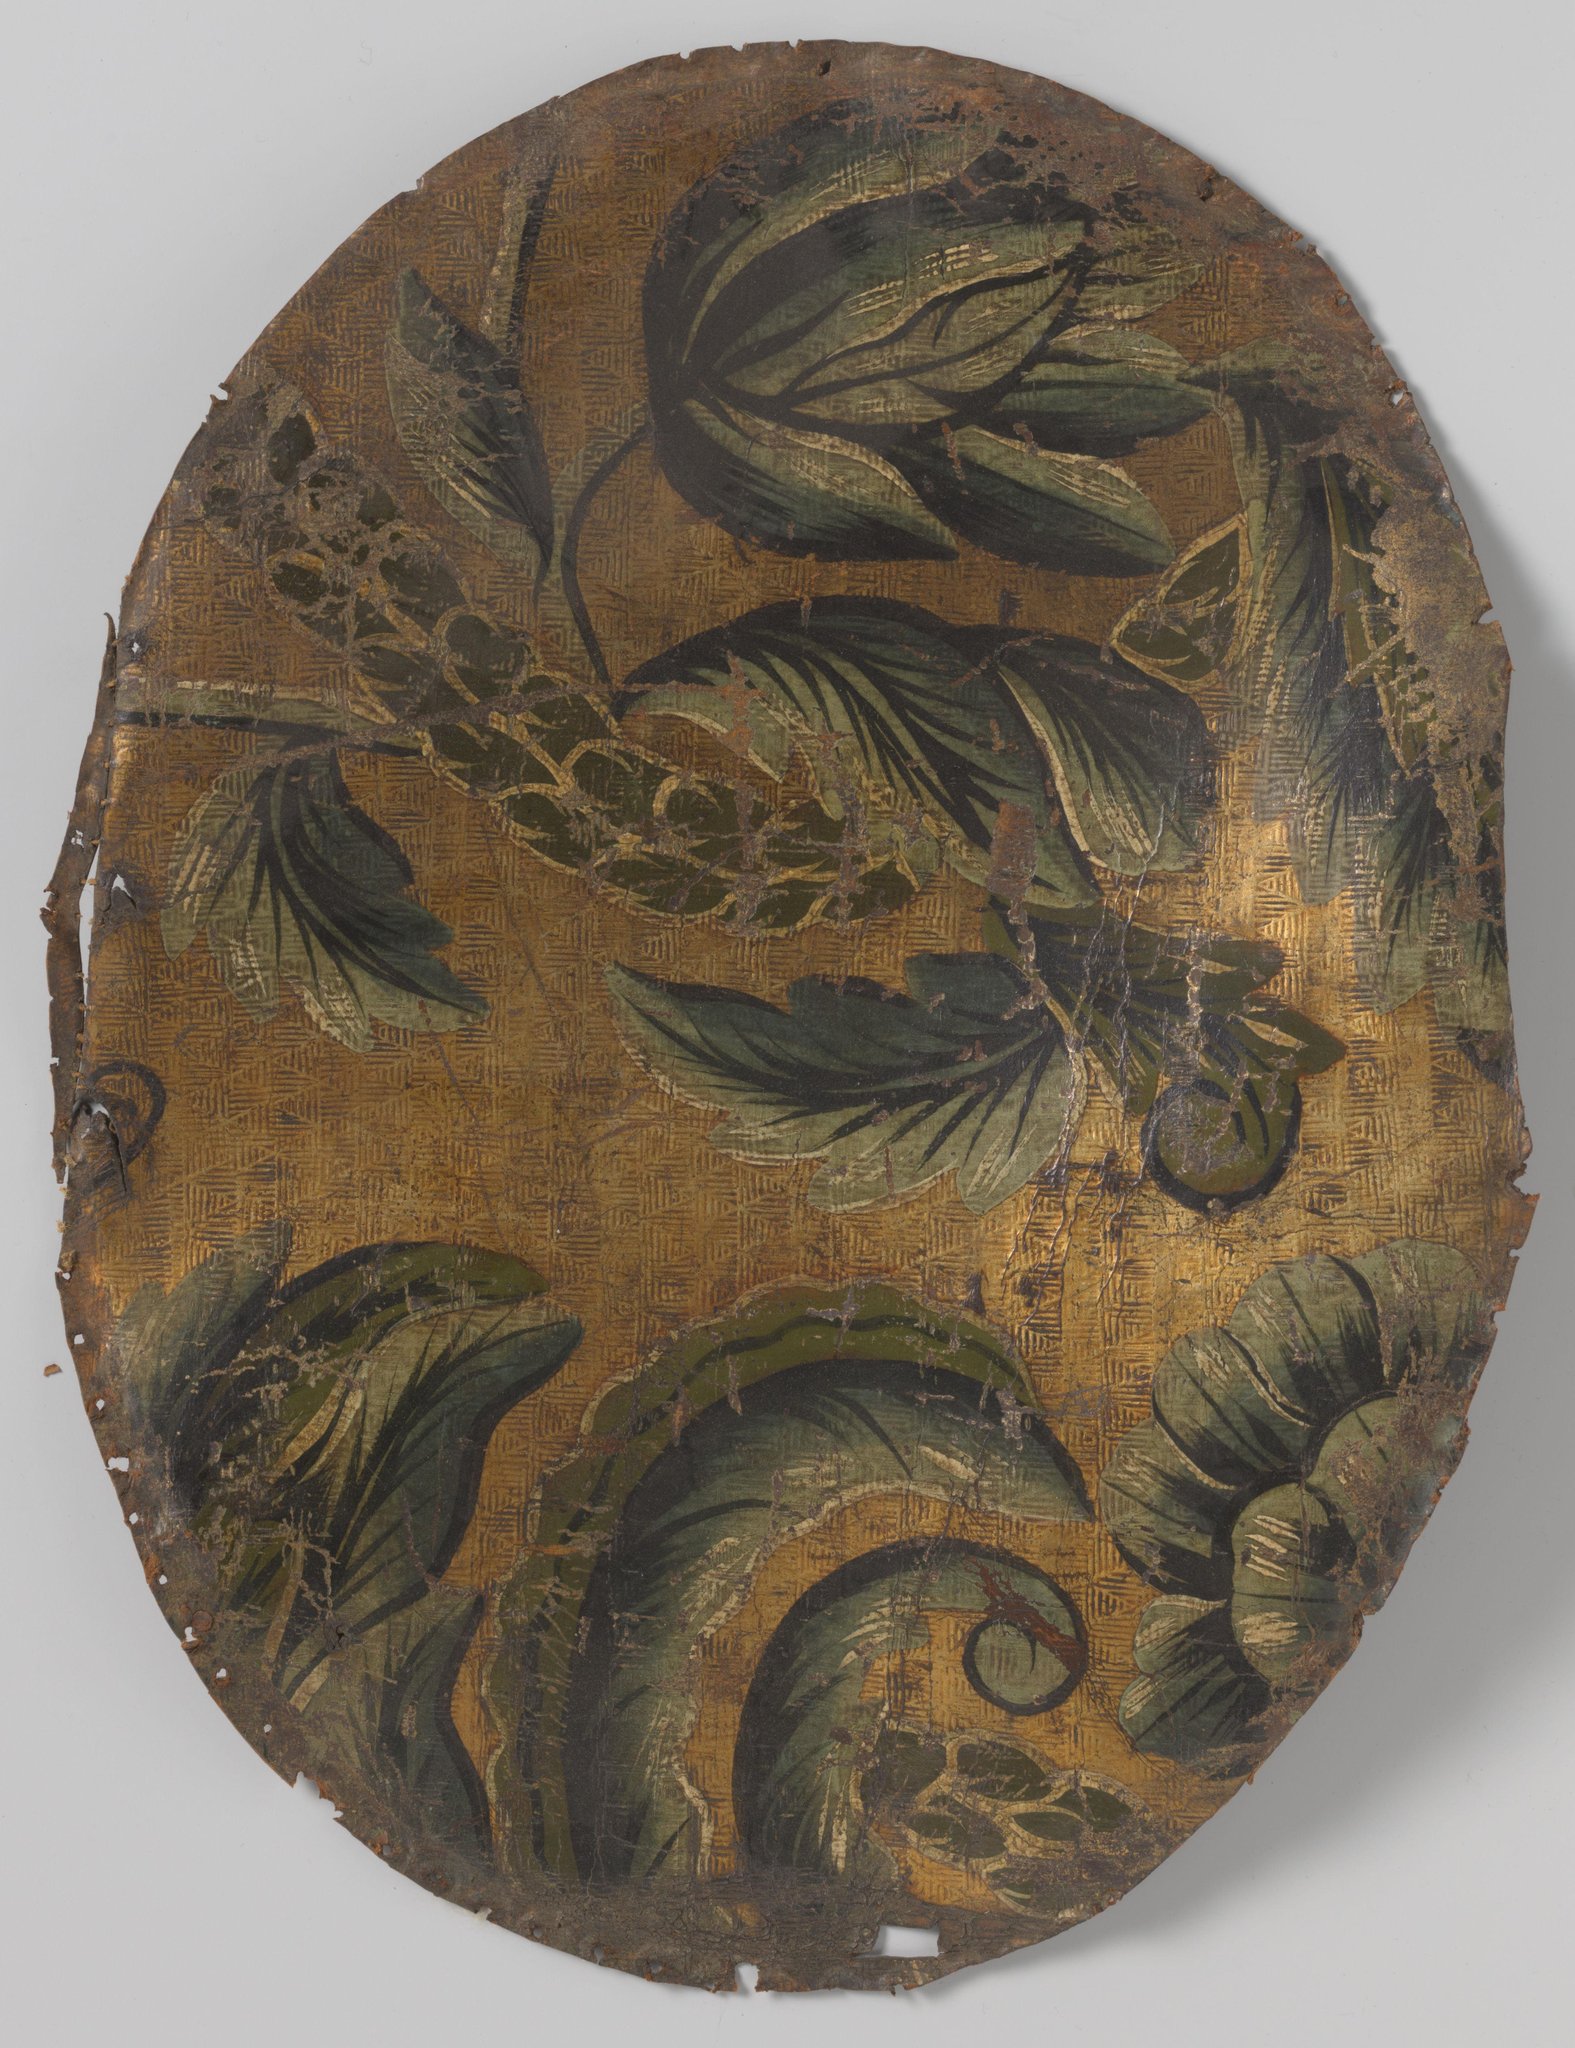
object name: stoelbekleding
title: Rugbekleding van een stoel van goudleer met patroon van bloemen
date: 1700-1800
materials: gilt leather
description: Rugbekleding van een stoel van goudleer met patroon van bloemen.